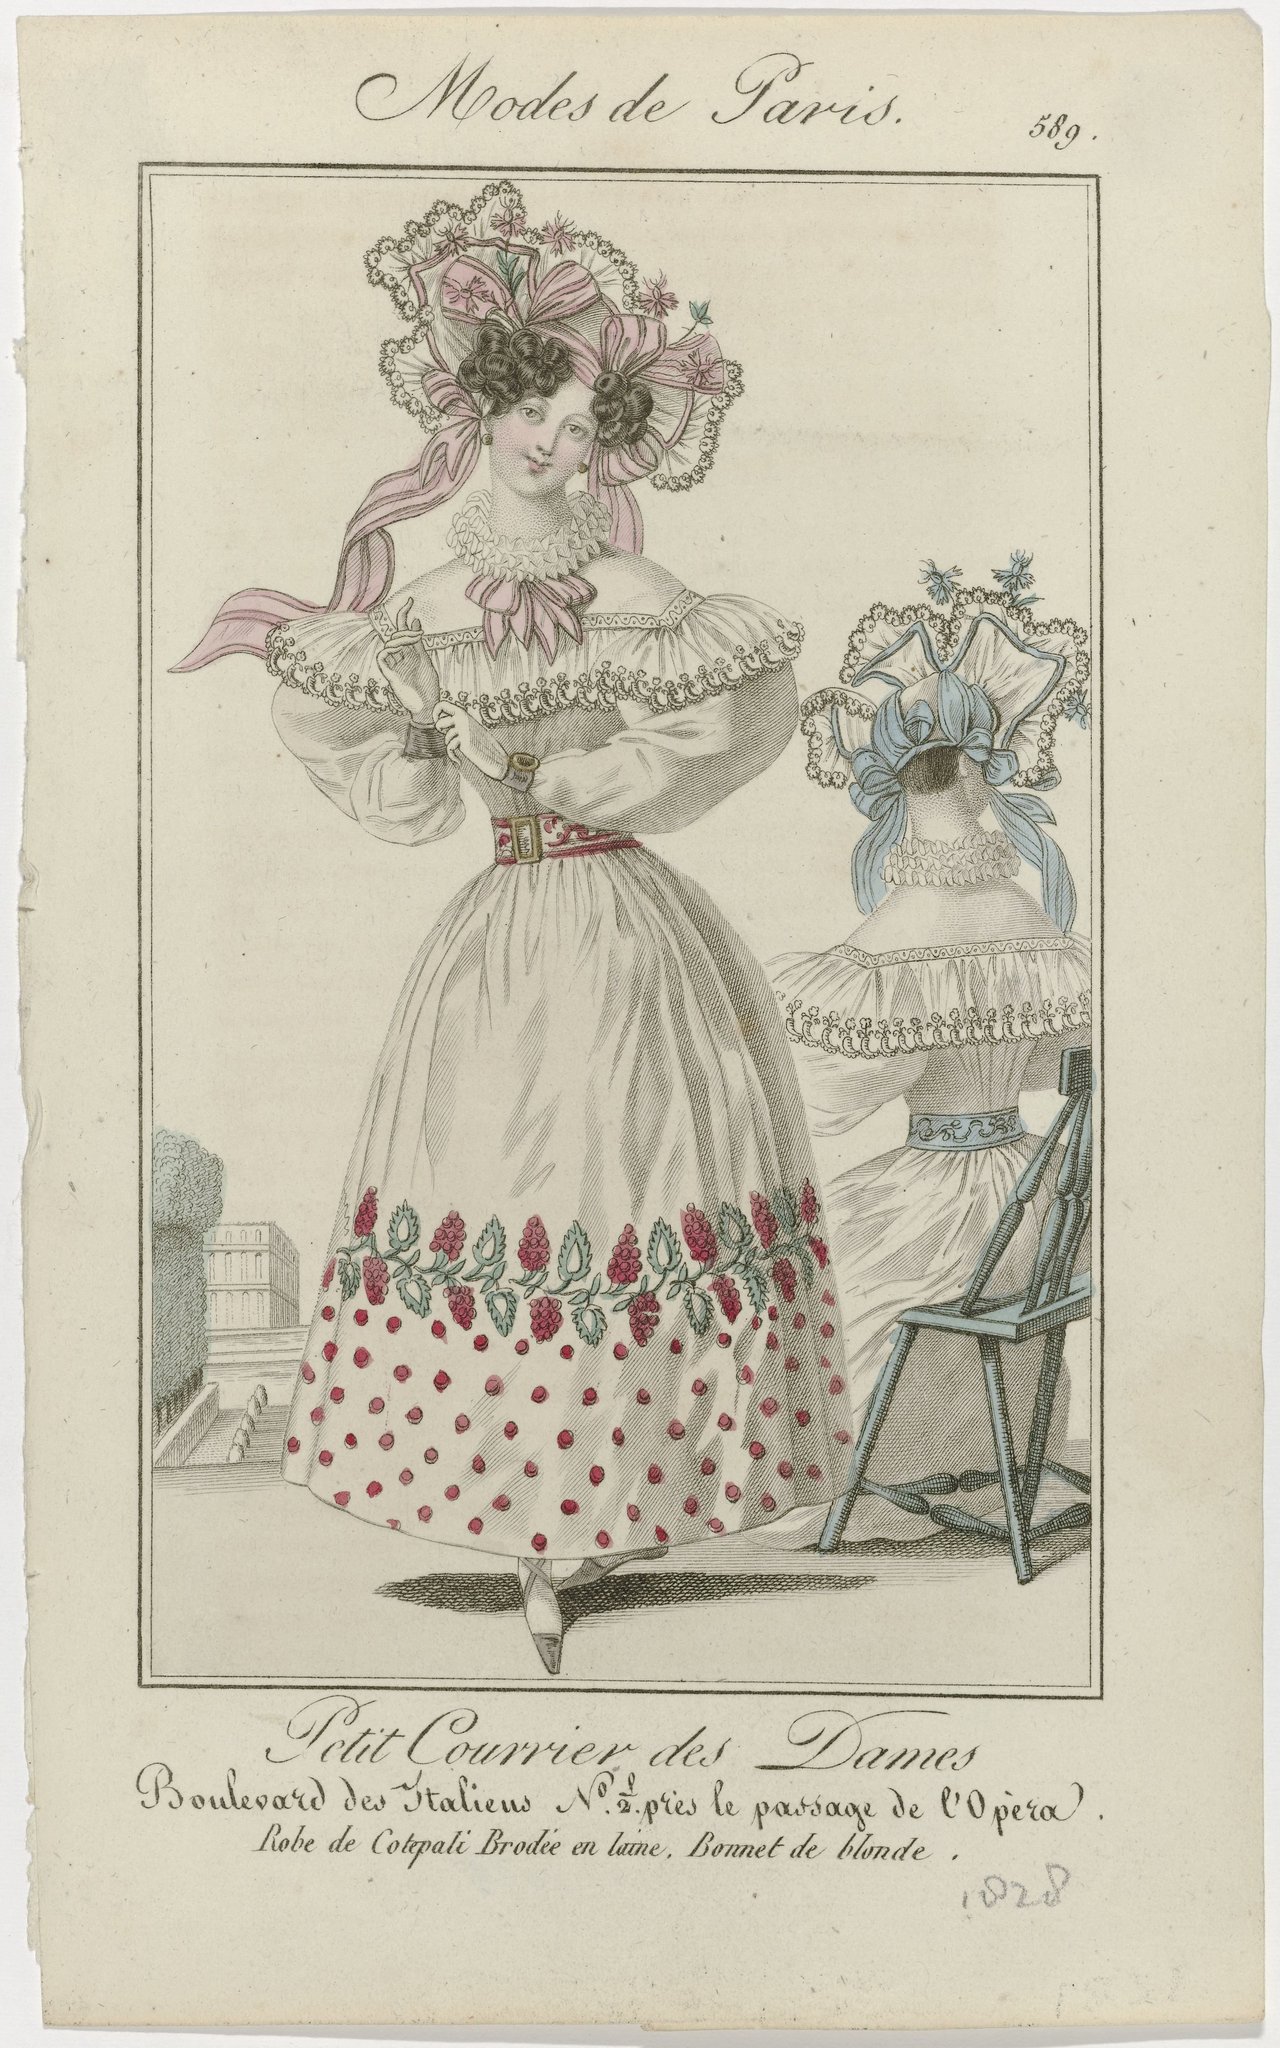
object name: fashion print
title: Petit Courrier des Dames, 1828, No. 589 : Robe de Cotepali Brodé (...)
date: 1828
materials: paper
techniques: engraving, hand coloring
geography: paris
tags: ear-rings (+ women's clothes), head-gear: cap (+ lace used for clothes), embroidery (ornamentation) (+ women's clothes), head-gear: cap (+ women's clothes), fashion plates, shoes, sandals (+ women's clothes), gloves, mittens, etc. (+ women's clothes), dress, gown (+ women's clothes), bracelet, wristlet (+ women's clothes), belt, girdle, waistband (+ women's clothes)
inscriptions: caption: ‘Robe de Cotepali brodée en laine. Bonnet de blonde.’, address: ‘Boulevard des Italiens No.2 près le passage de l'Opèra.’, title: ‘Modes de Paris.’, title: ‘Petit Courrier des Dames.’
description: Vrouw gekleed in een japon van 'cotepali' met borduurwerk in wol. Op het hoofd een muts van Blonde (kloskant) met gestreepte linten. Verdere accessoires: oorbellen, armbanden om beide polsen, handschoenen, ceintuur met gesp, platte schoenen met gekruiste banden. Prent uit het modetijdschrift Petit Courrier des Dames (1821-1868).